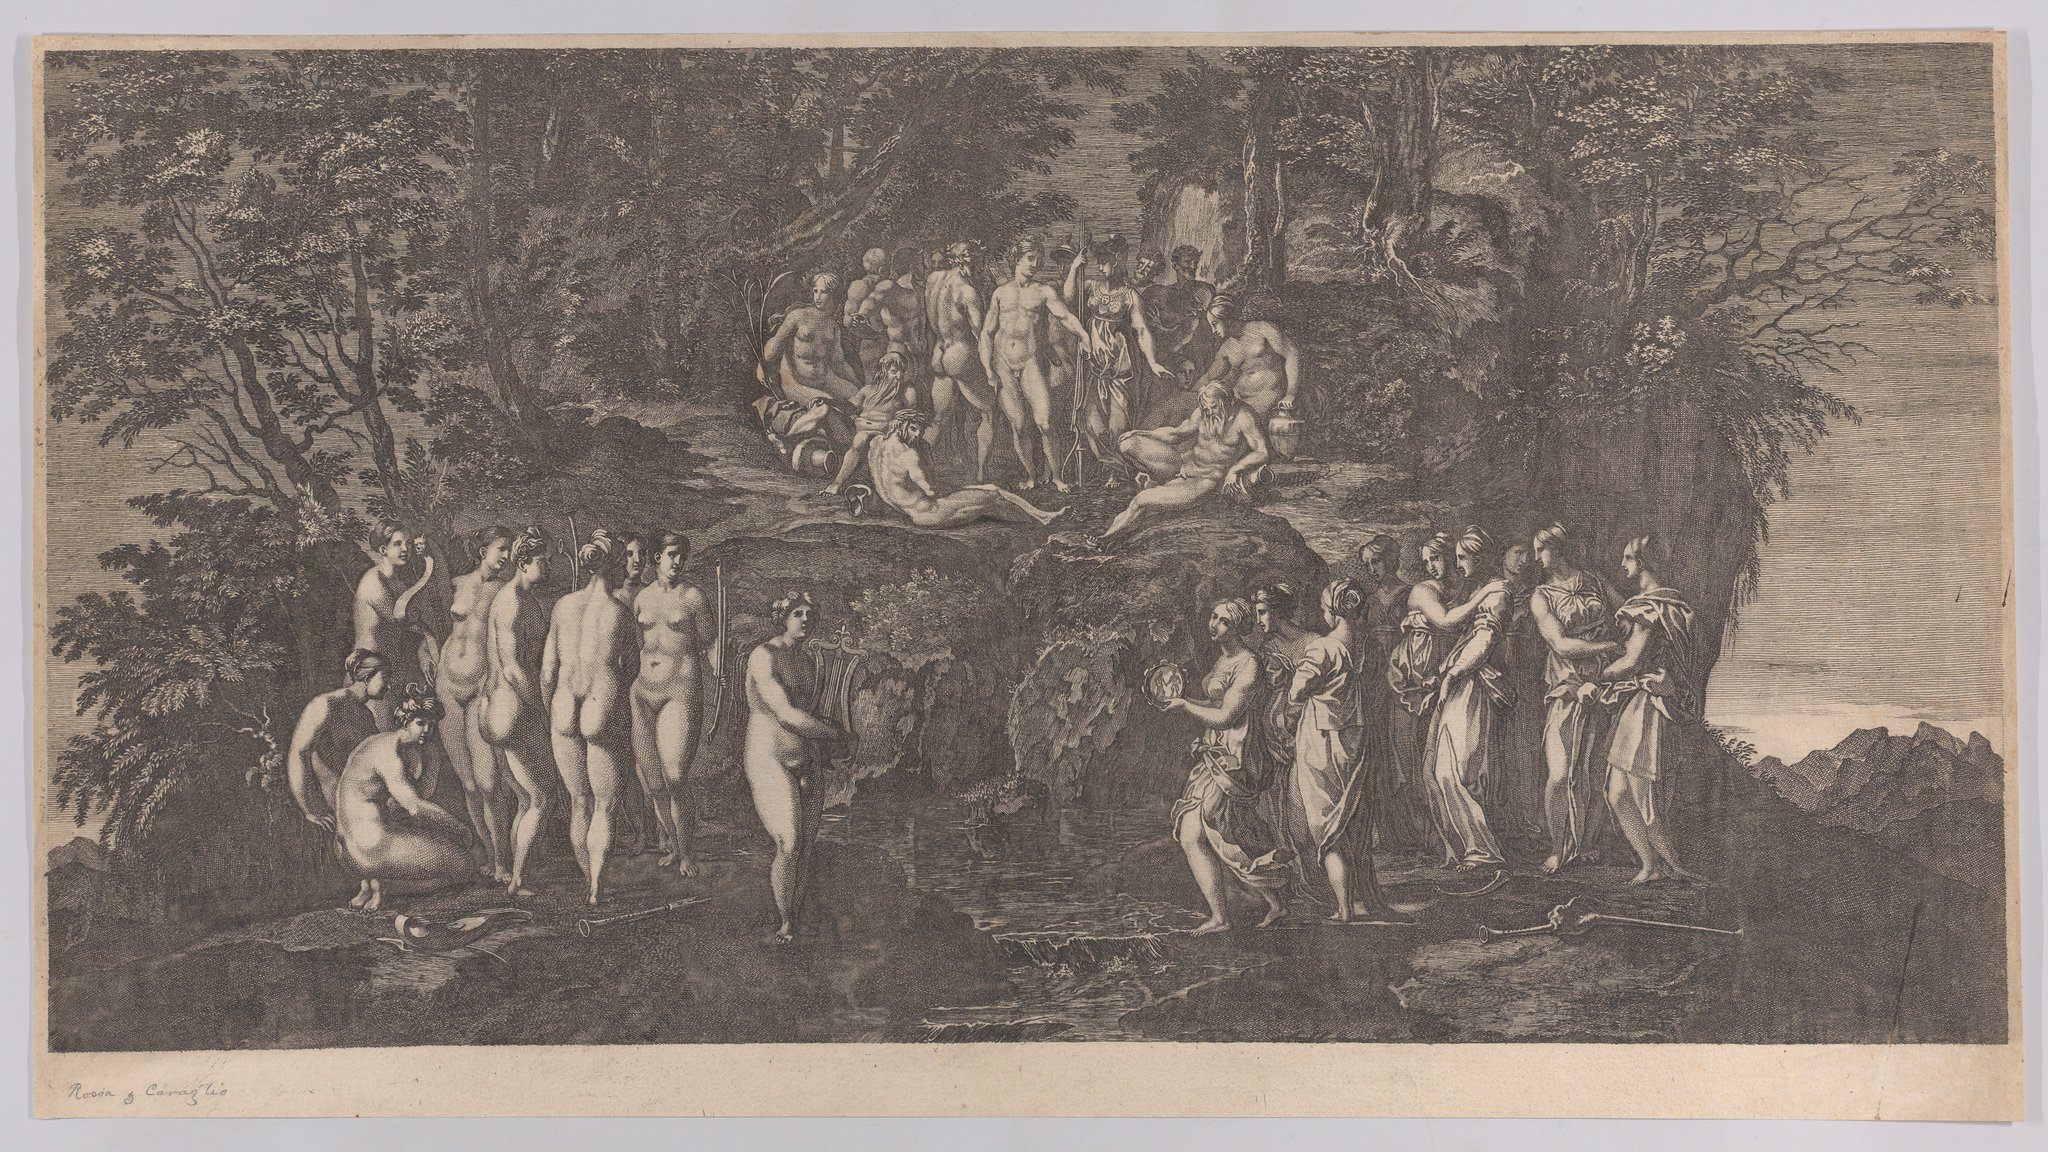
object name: print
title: The musical contest between the Muses on one side and the Pierides on the other, judged by the gods of Olympus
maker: Anonymous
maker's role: artist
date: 1750-1850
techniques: etching